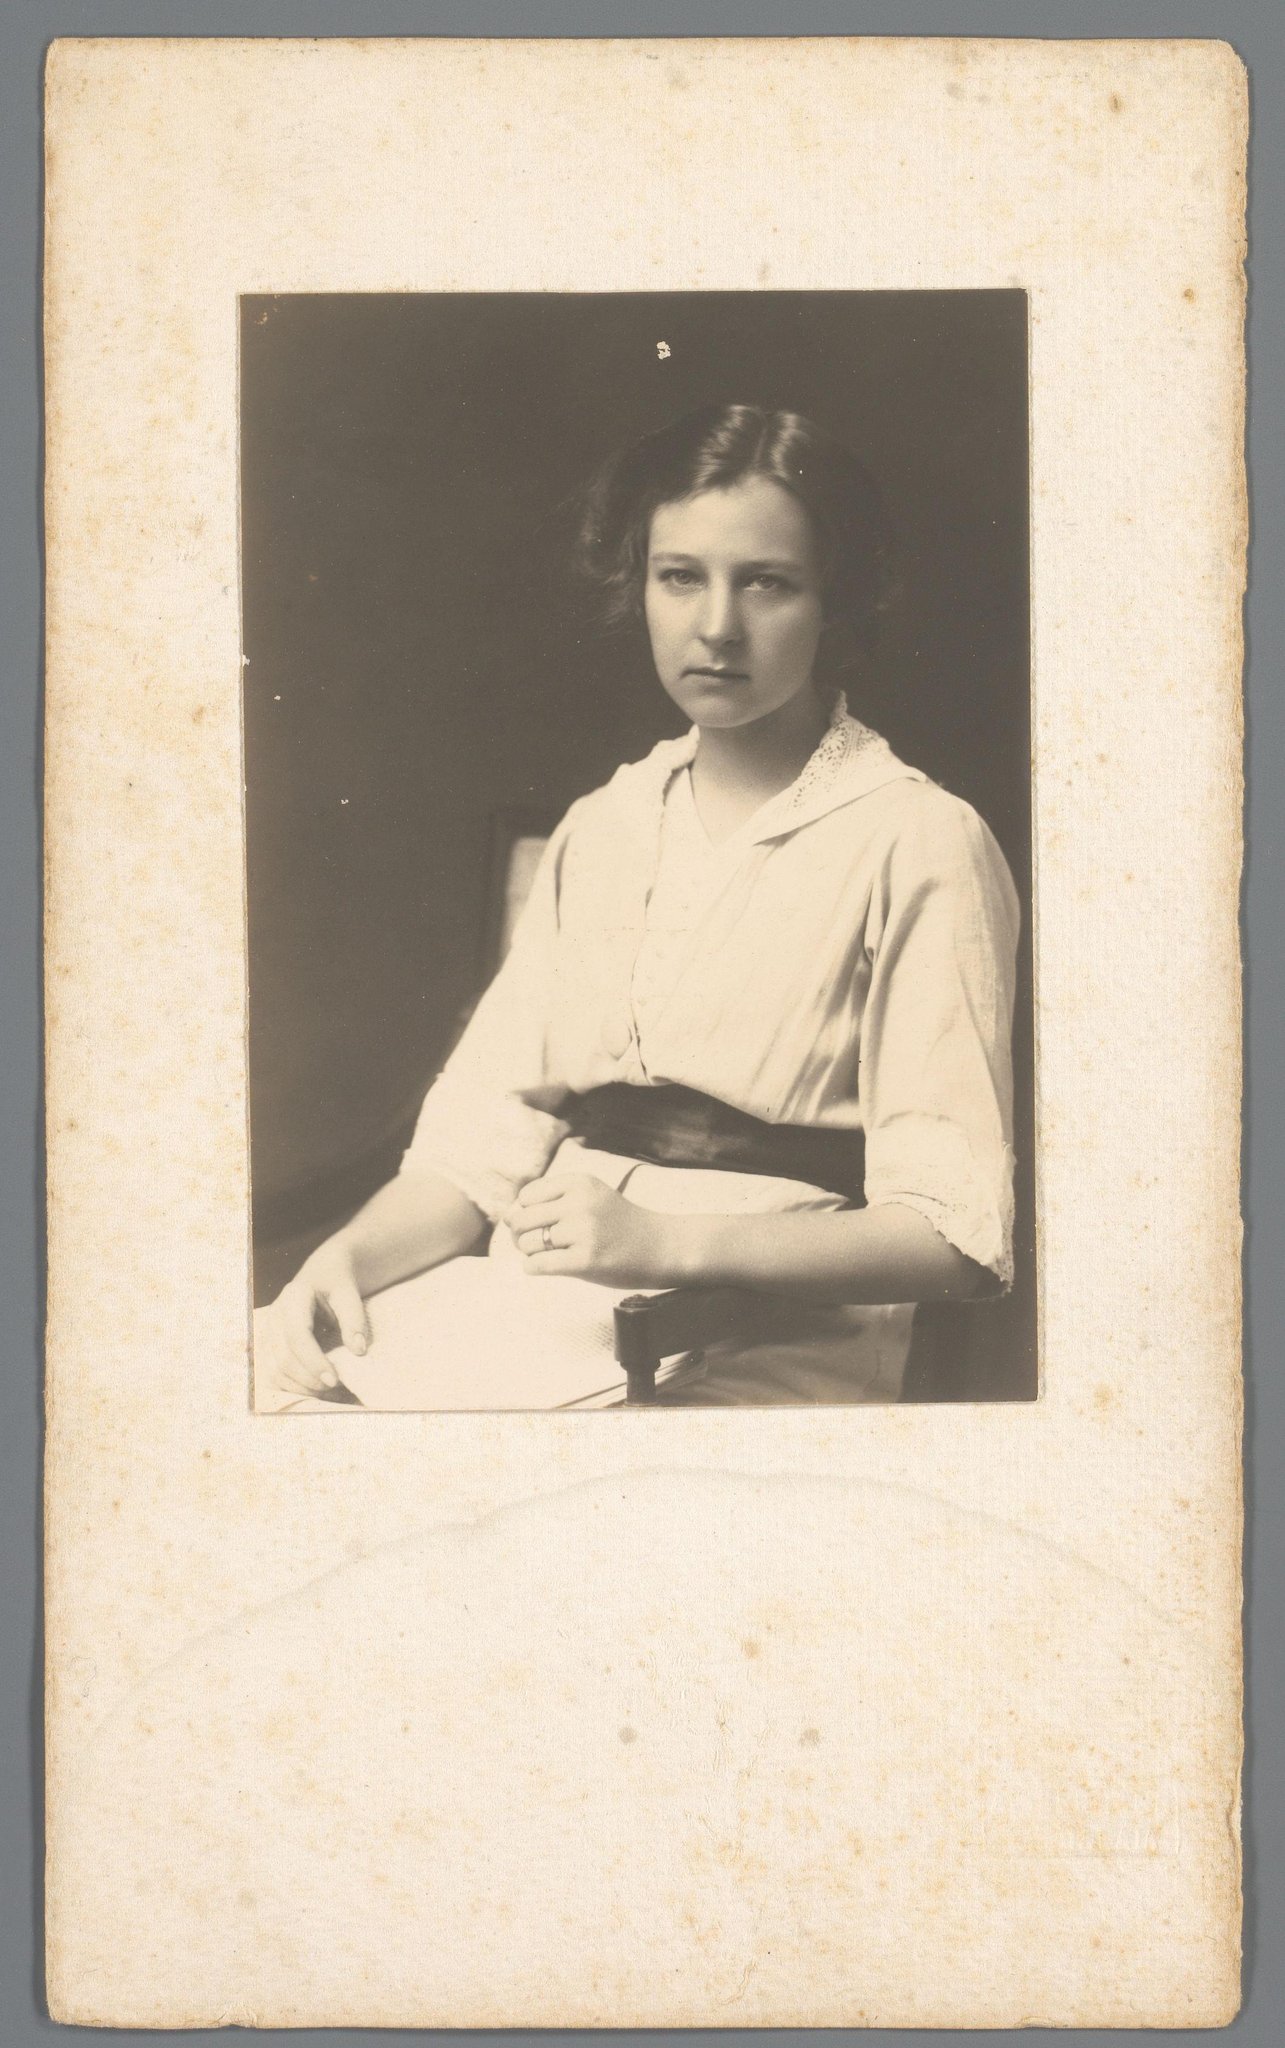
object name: photograph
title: Portret van een onbekende vrouw, Soerabaja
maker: a. herrmann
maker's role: fotograaf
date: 1910-1930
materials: paper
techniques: gelatin silver print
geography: surabaya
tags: historical persons not known by name - bb - woman, surabaya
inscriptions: check stamp: ‘A. Herrmann/ Soerabaja’